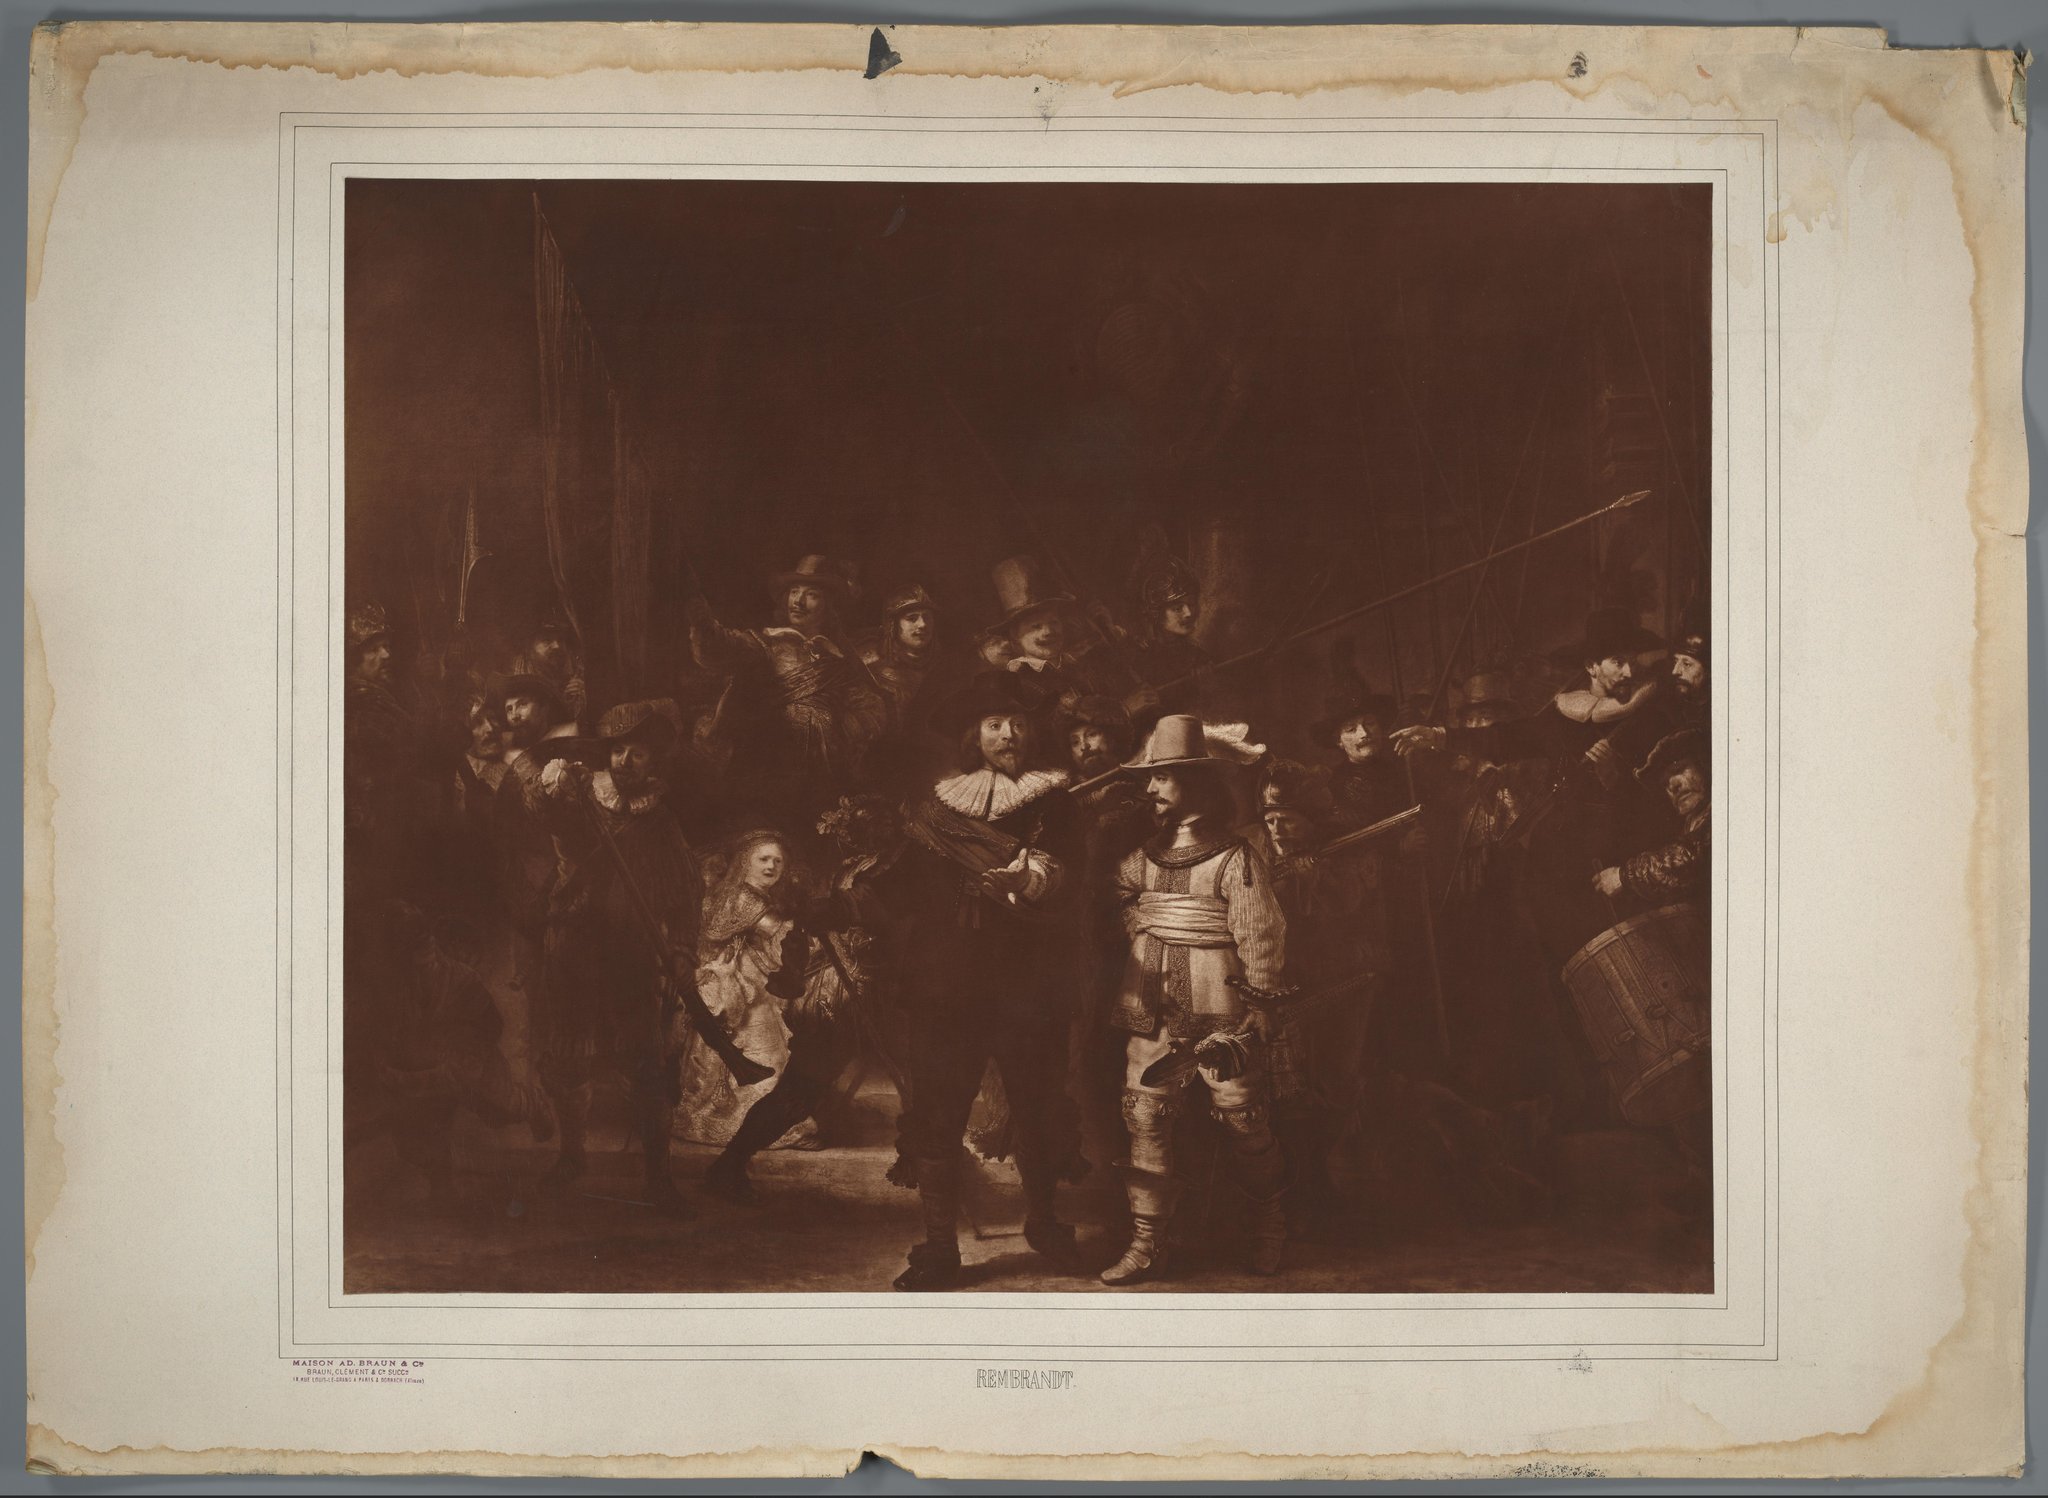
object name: reproduction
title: Fotoreproductie van De Nachtwacht door Rembrandt van Rijn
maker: rembrandt van rijn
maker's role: draughtsman, painter, print maker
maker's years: 1606-1669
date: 1863-1906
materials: cardboard, photographic support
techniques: carbon print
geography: paris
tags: frans banninck cocq, warfare; military affairs (+ citizen soldiery, civil guard, citizen militia), picture, painting, land forces (+ citizen soldiery, civil guard, citizen militia), amsterdam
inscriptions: inscription: ‘R: MVS.’, name: ‘REMBRANDT’, number: ‘'06.131’, stamp: ‘MAISON AD. BRAUN & Cie/ BRAUN, CLÉMENT & Cie SUCCes/ 18 RUE LOUIS-LE-GRAND A PARIS & DORNACH (Alsaec)’